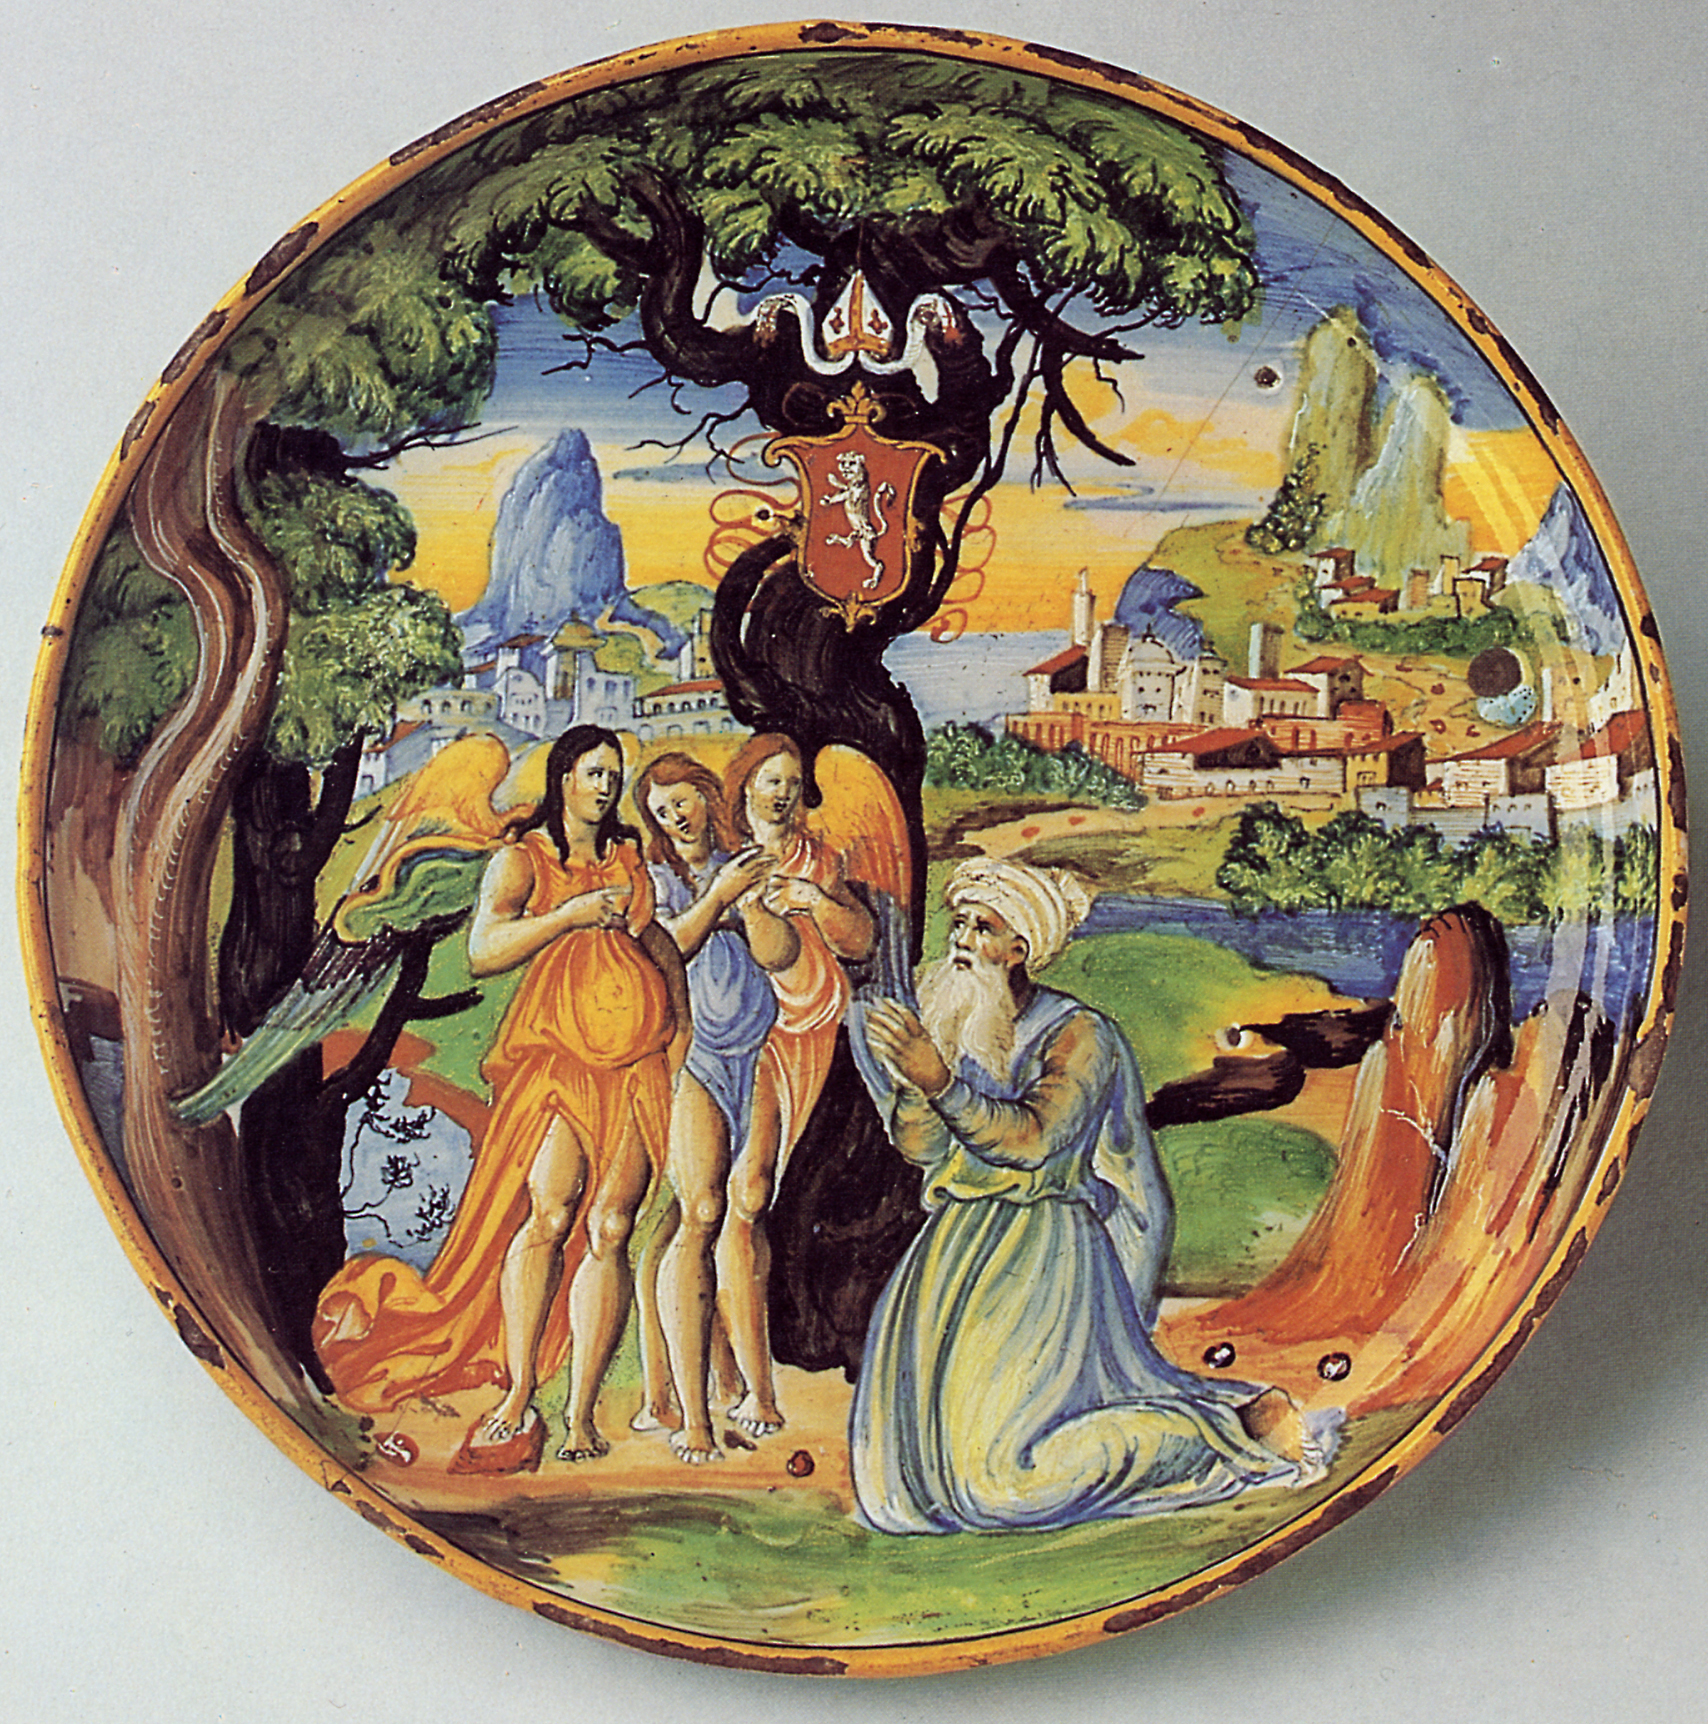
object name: dish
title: Dish (coppa)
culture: italian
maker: workshop of guido durantino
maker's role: artist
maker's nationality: italian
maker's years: 1516-1581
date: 1535-1540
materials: earthenware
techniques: maiolica, glazing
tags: men,angels,coat of arms